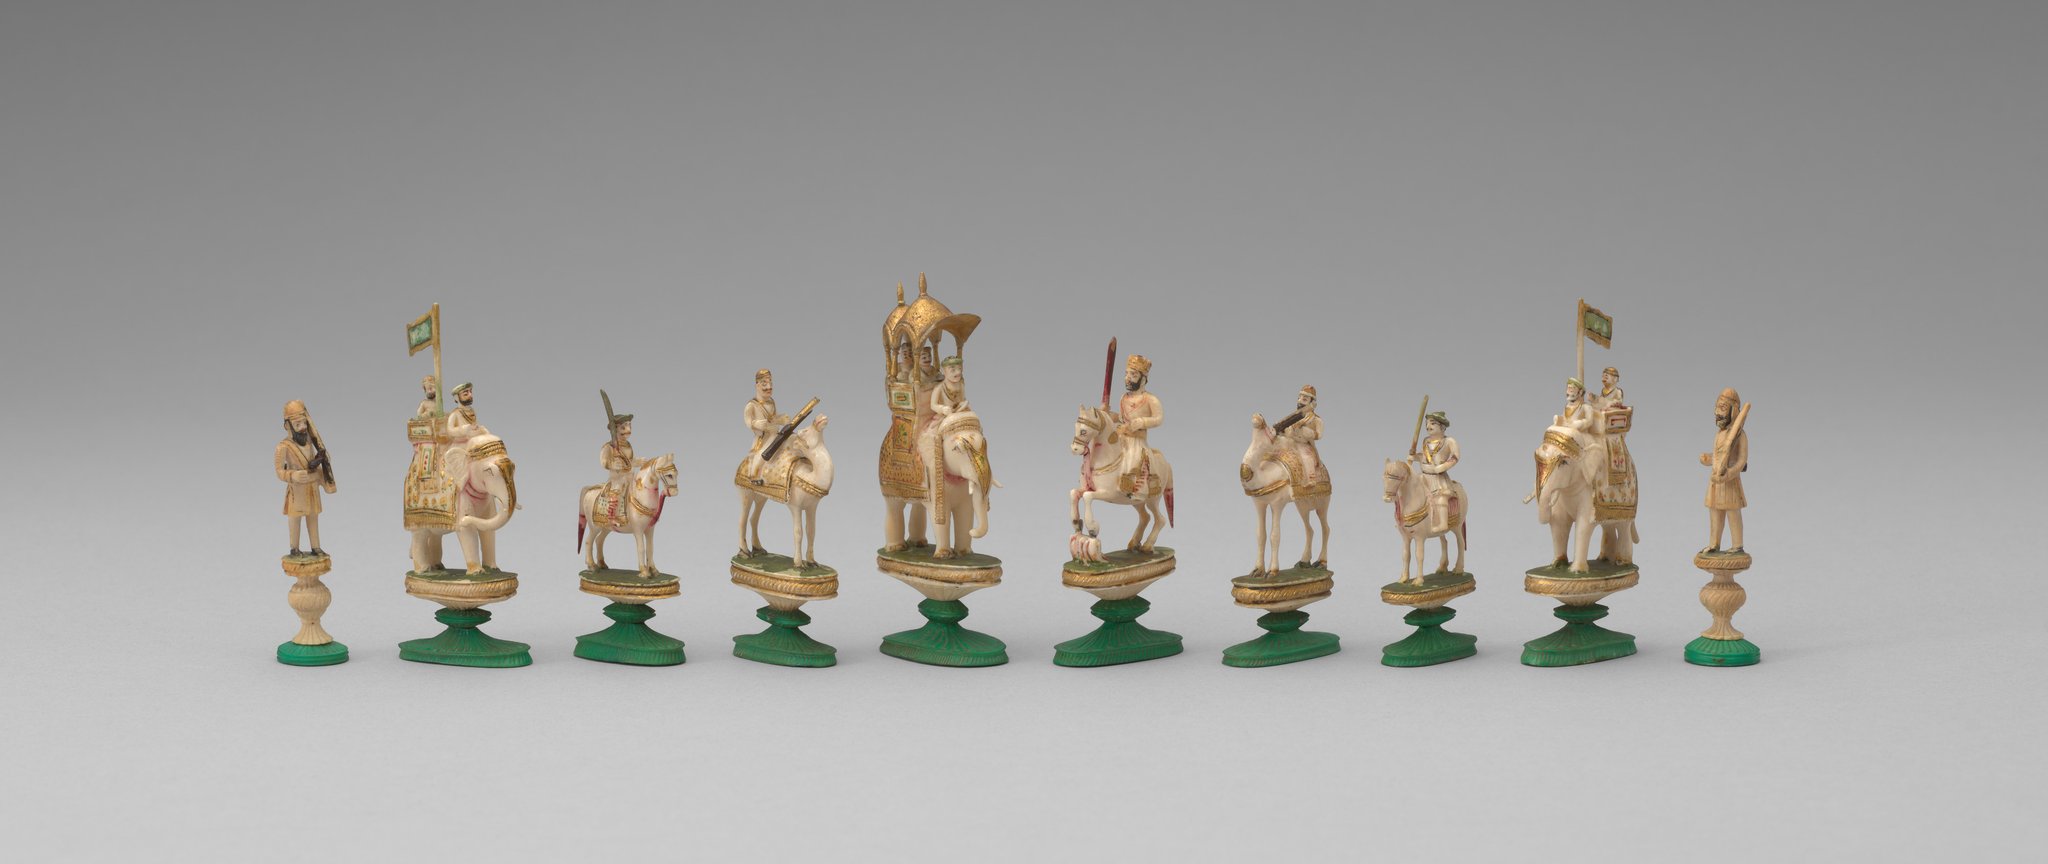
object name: chessman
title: Chessmen (30)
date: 1801-1900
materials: ivory